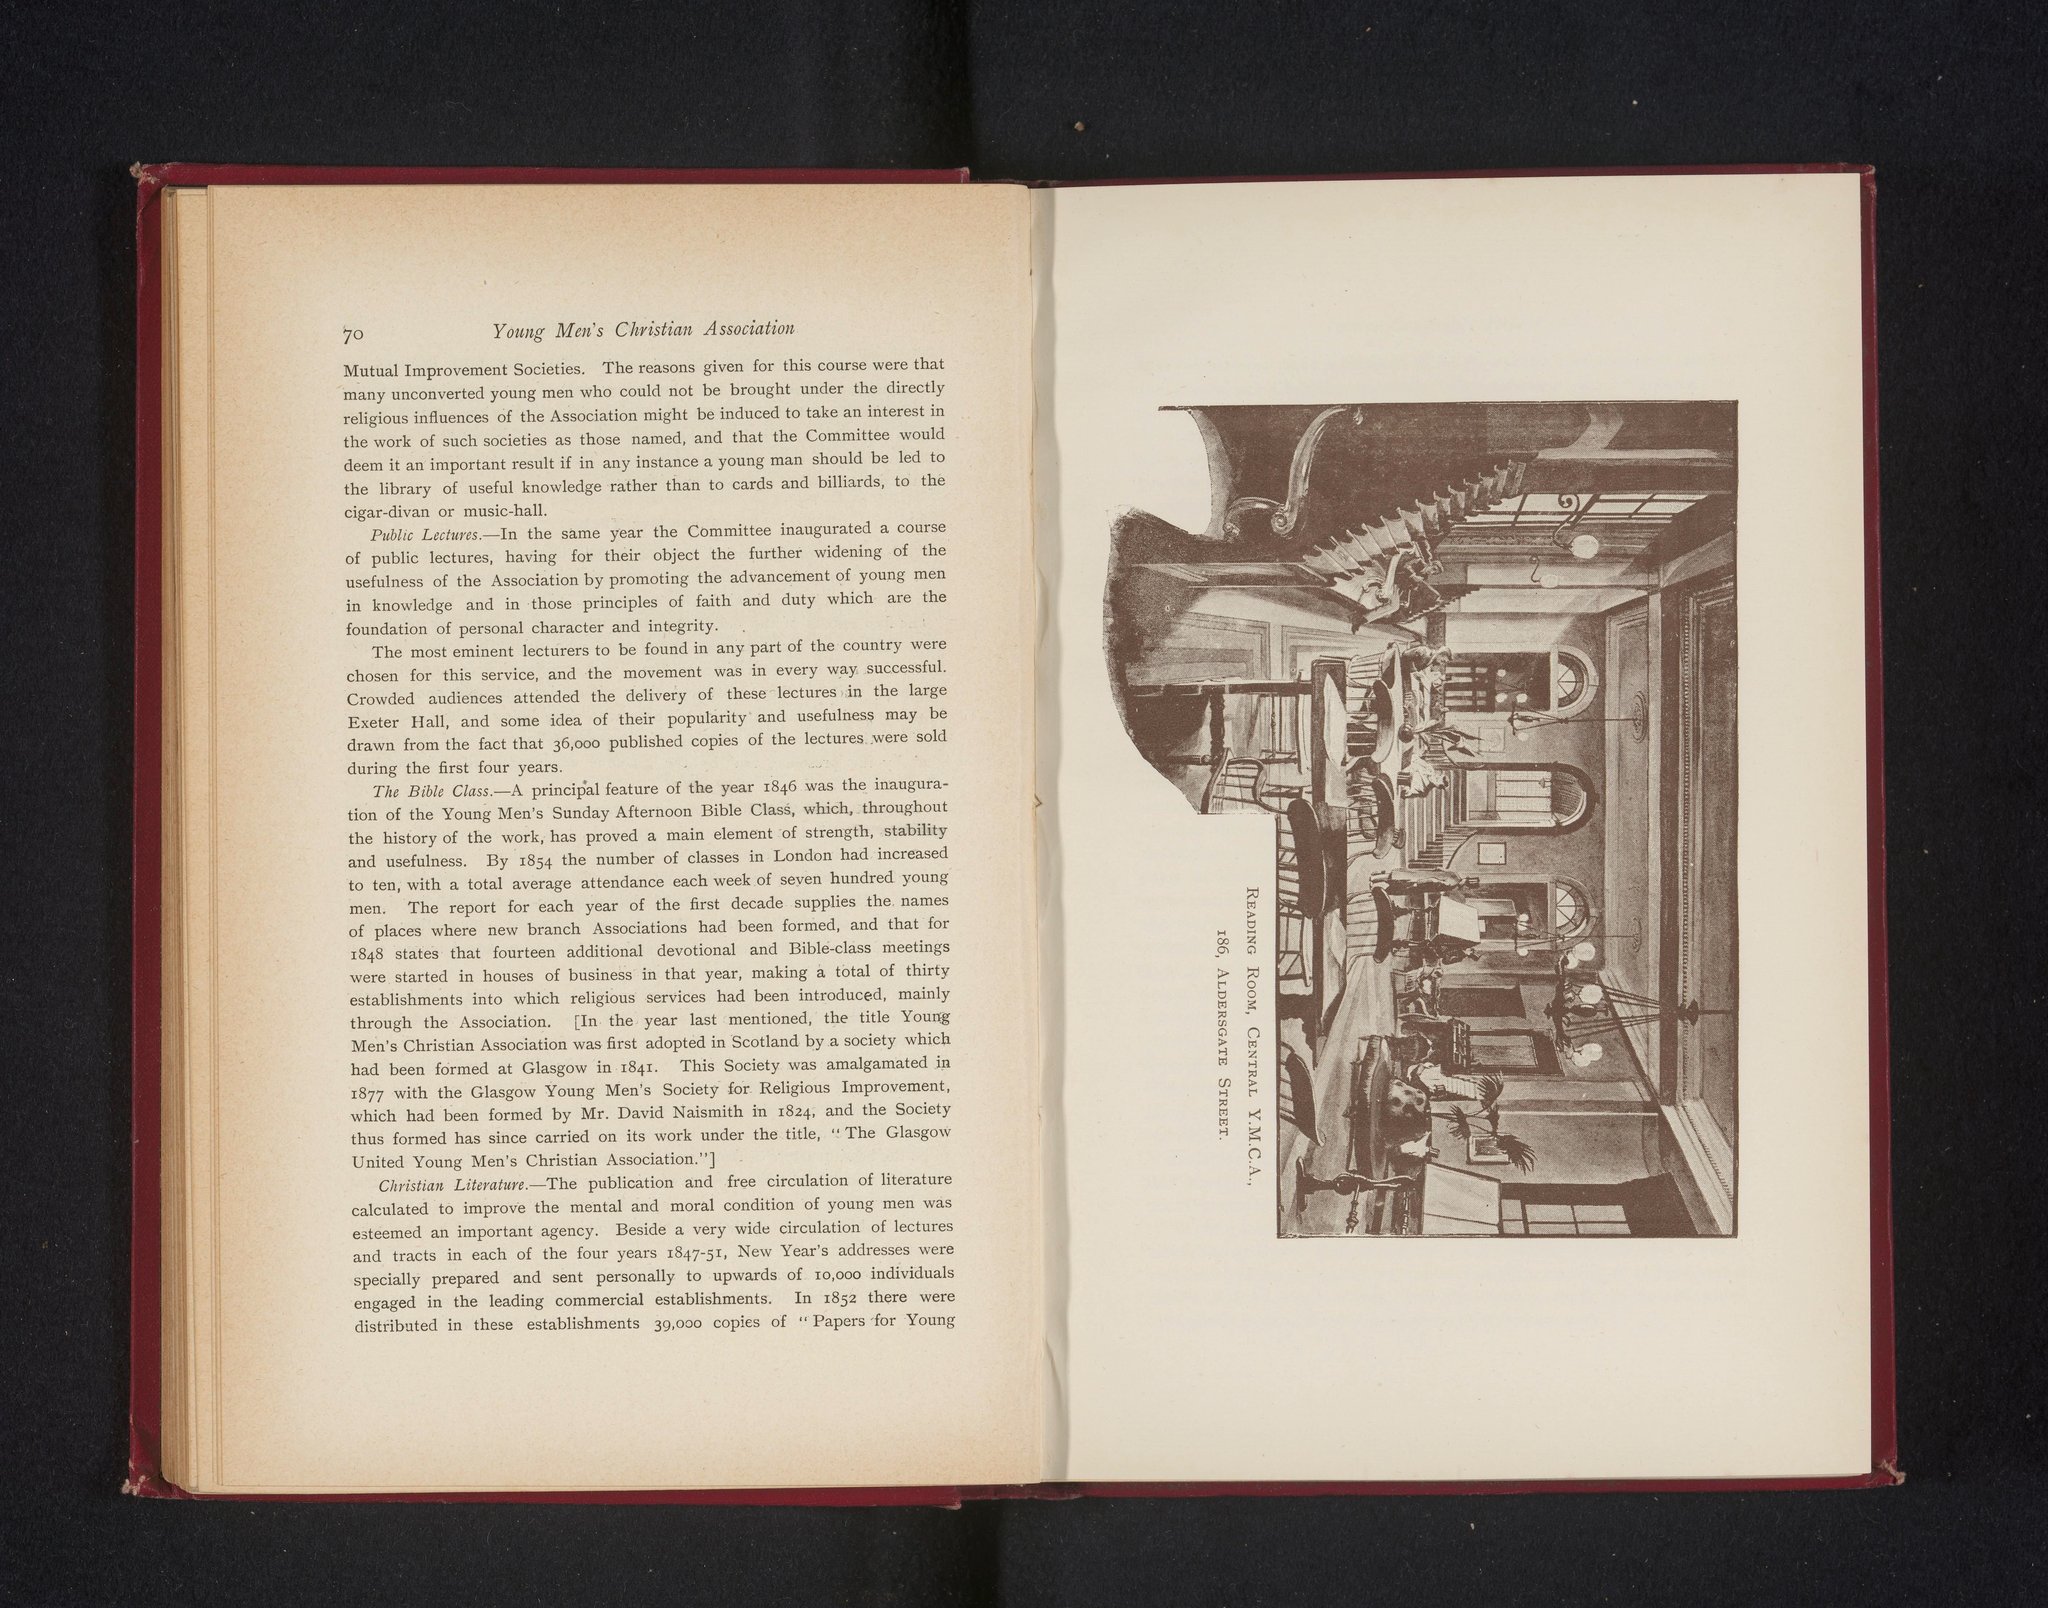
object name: photomechanical print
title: Reproductie van een tekening van de leeszaal van de Young Men's Christian Association in Londen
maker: Anonymous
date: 1890-1895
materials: paper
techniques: autotype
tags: reading, living-room, parlour, sitting-room, london